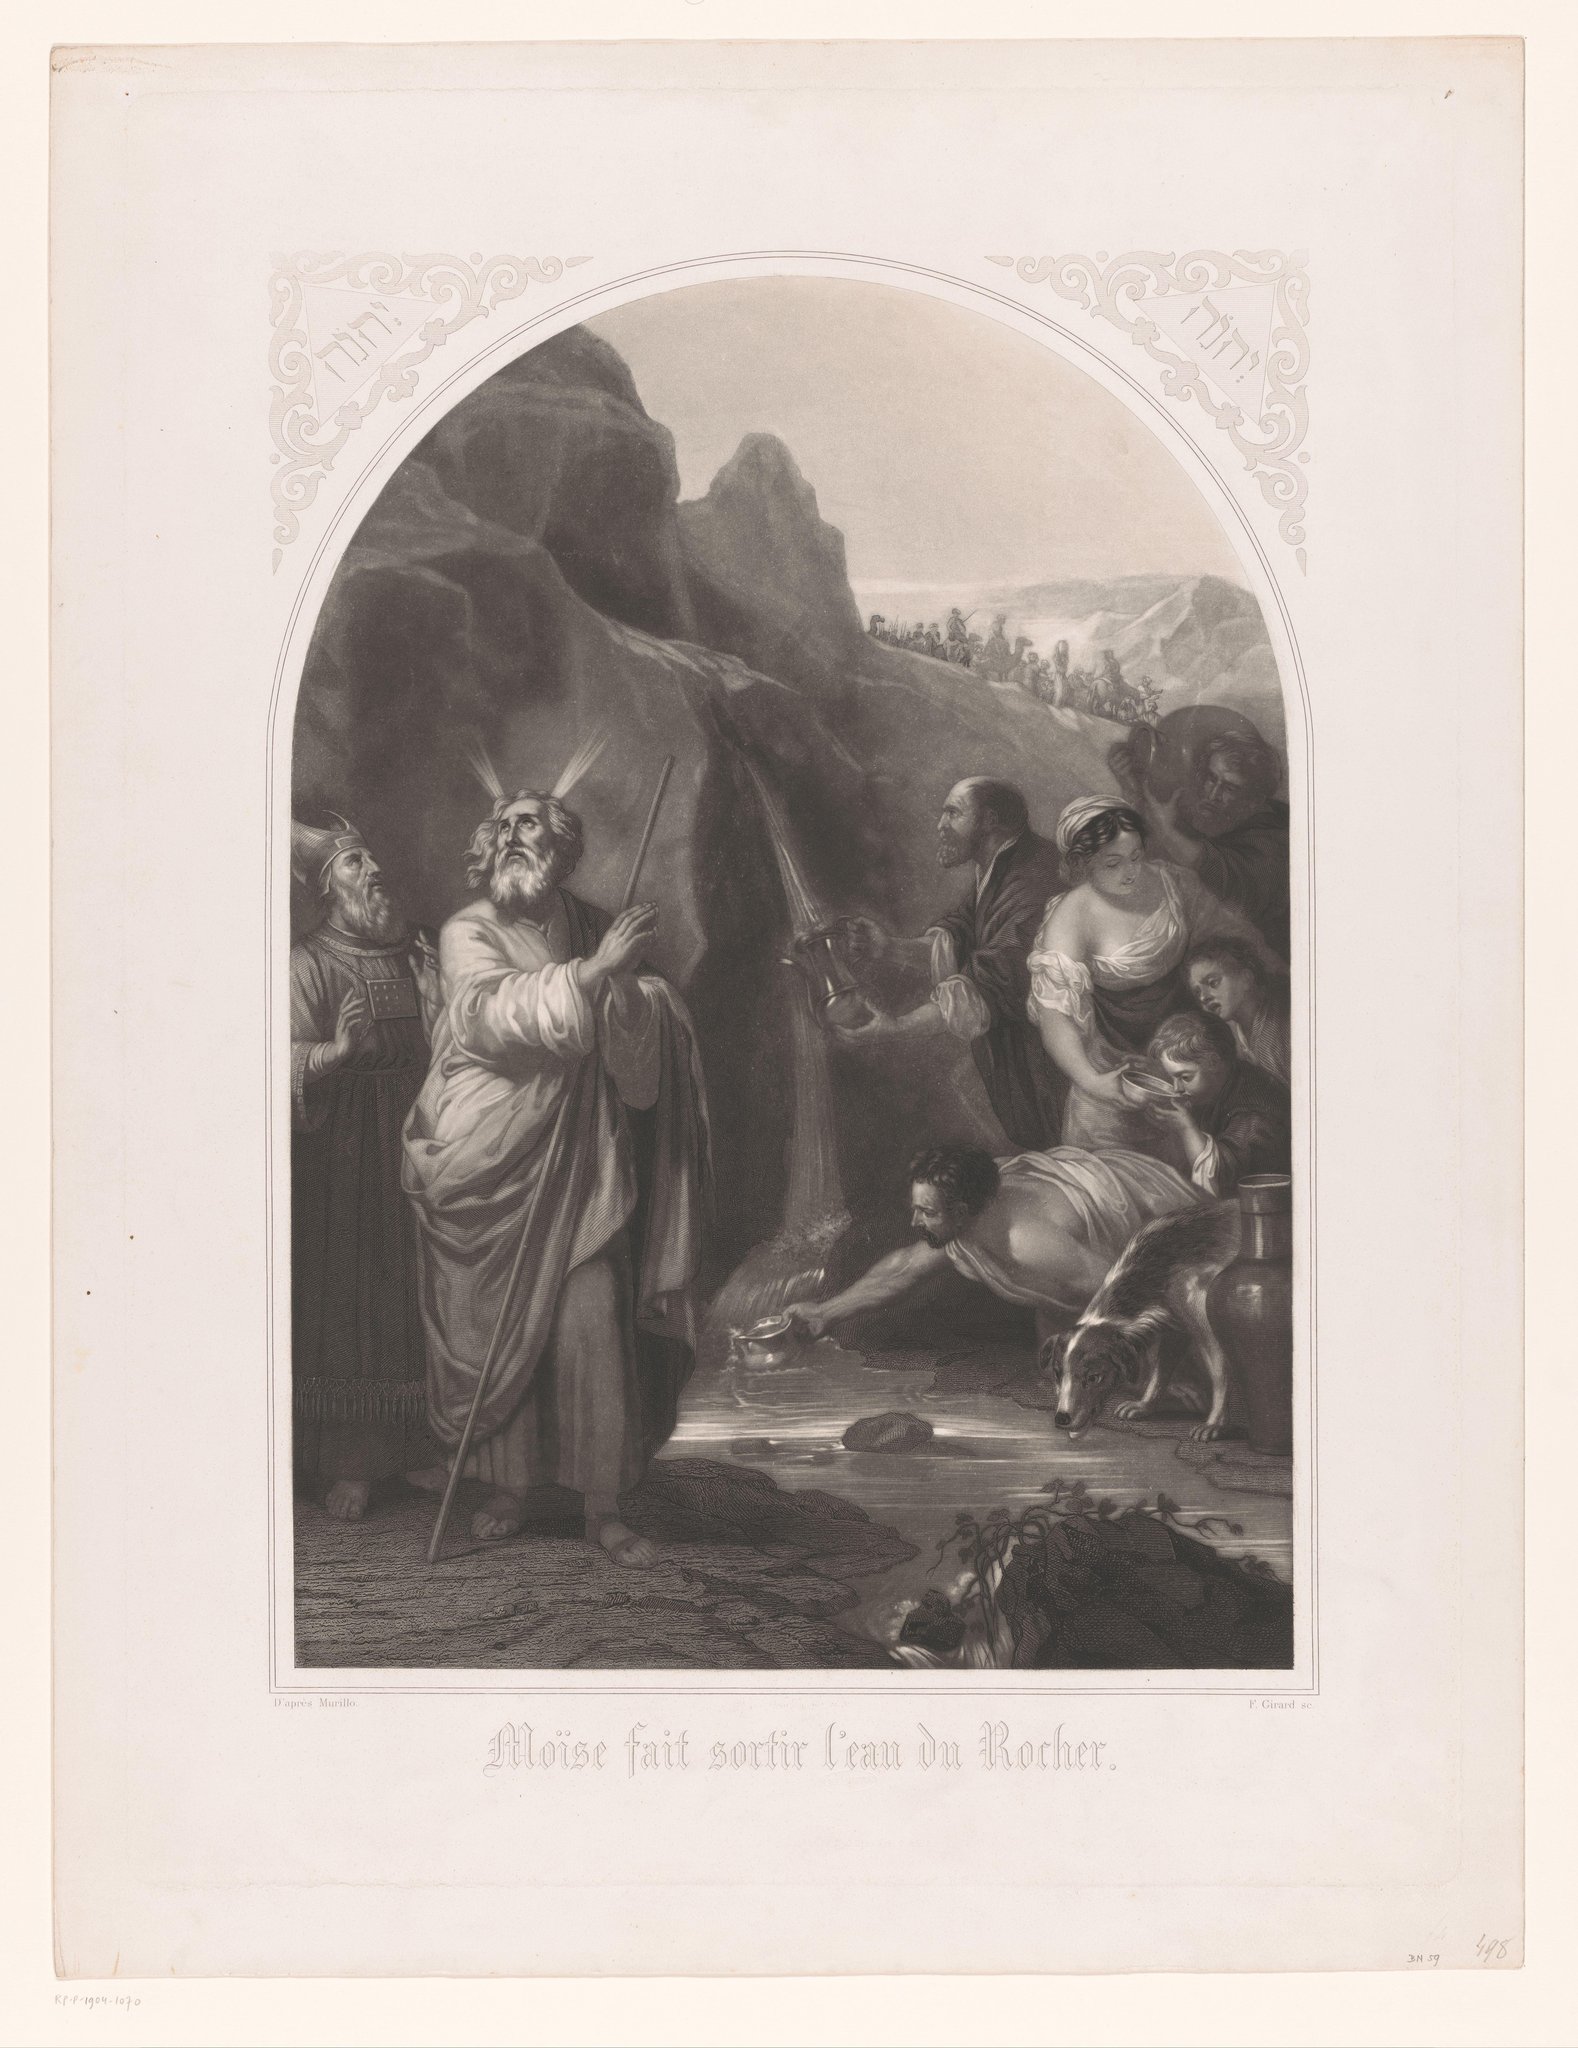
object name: print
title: Mozes slaat water uit de rots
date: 1797-1870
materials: paper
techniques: aquatint, etching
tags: moses striking water from the rock (exodus 17:1-7; numbers 20:2-13)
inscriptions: collector's mark: Lugt 2228a, check stamp: Lugt 3992